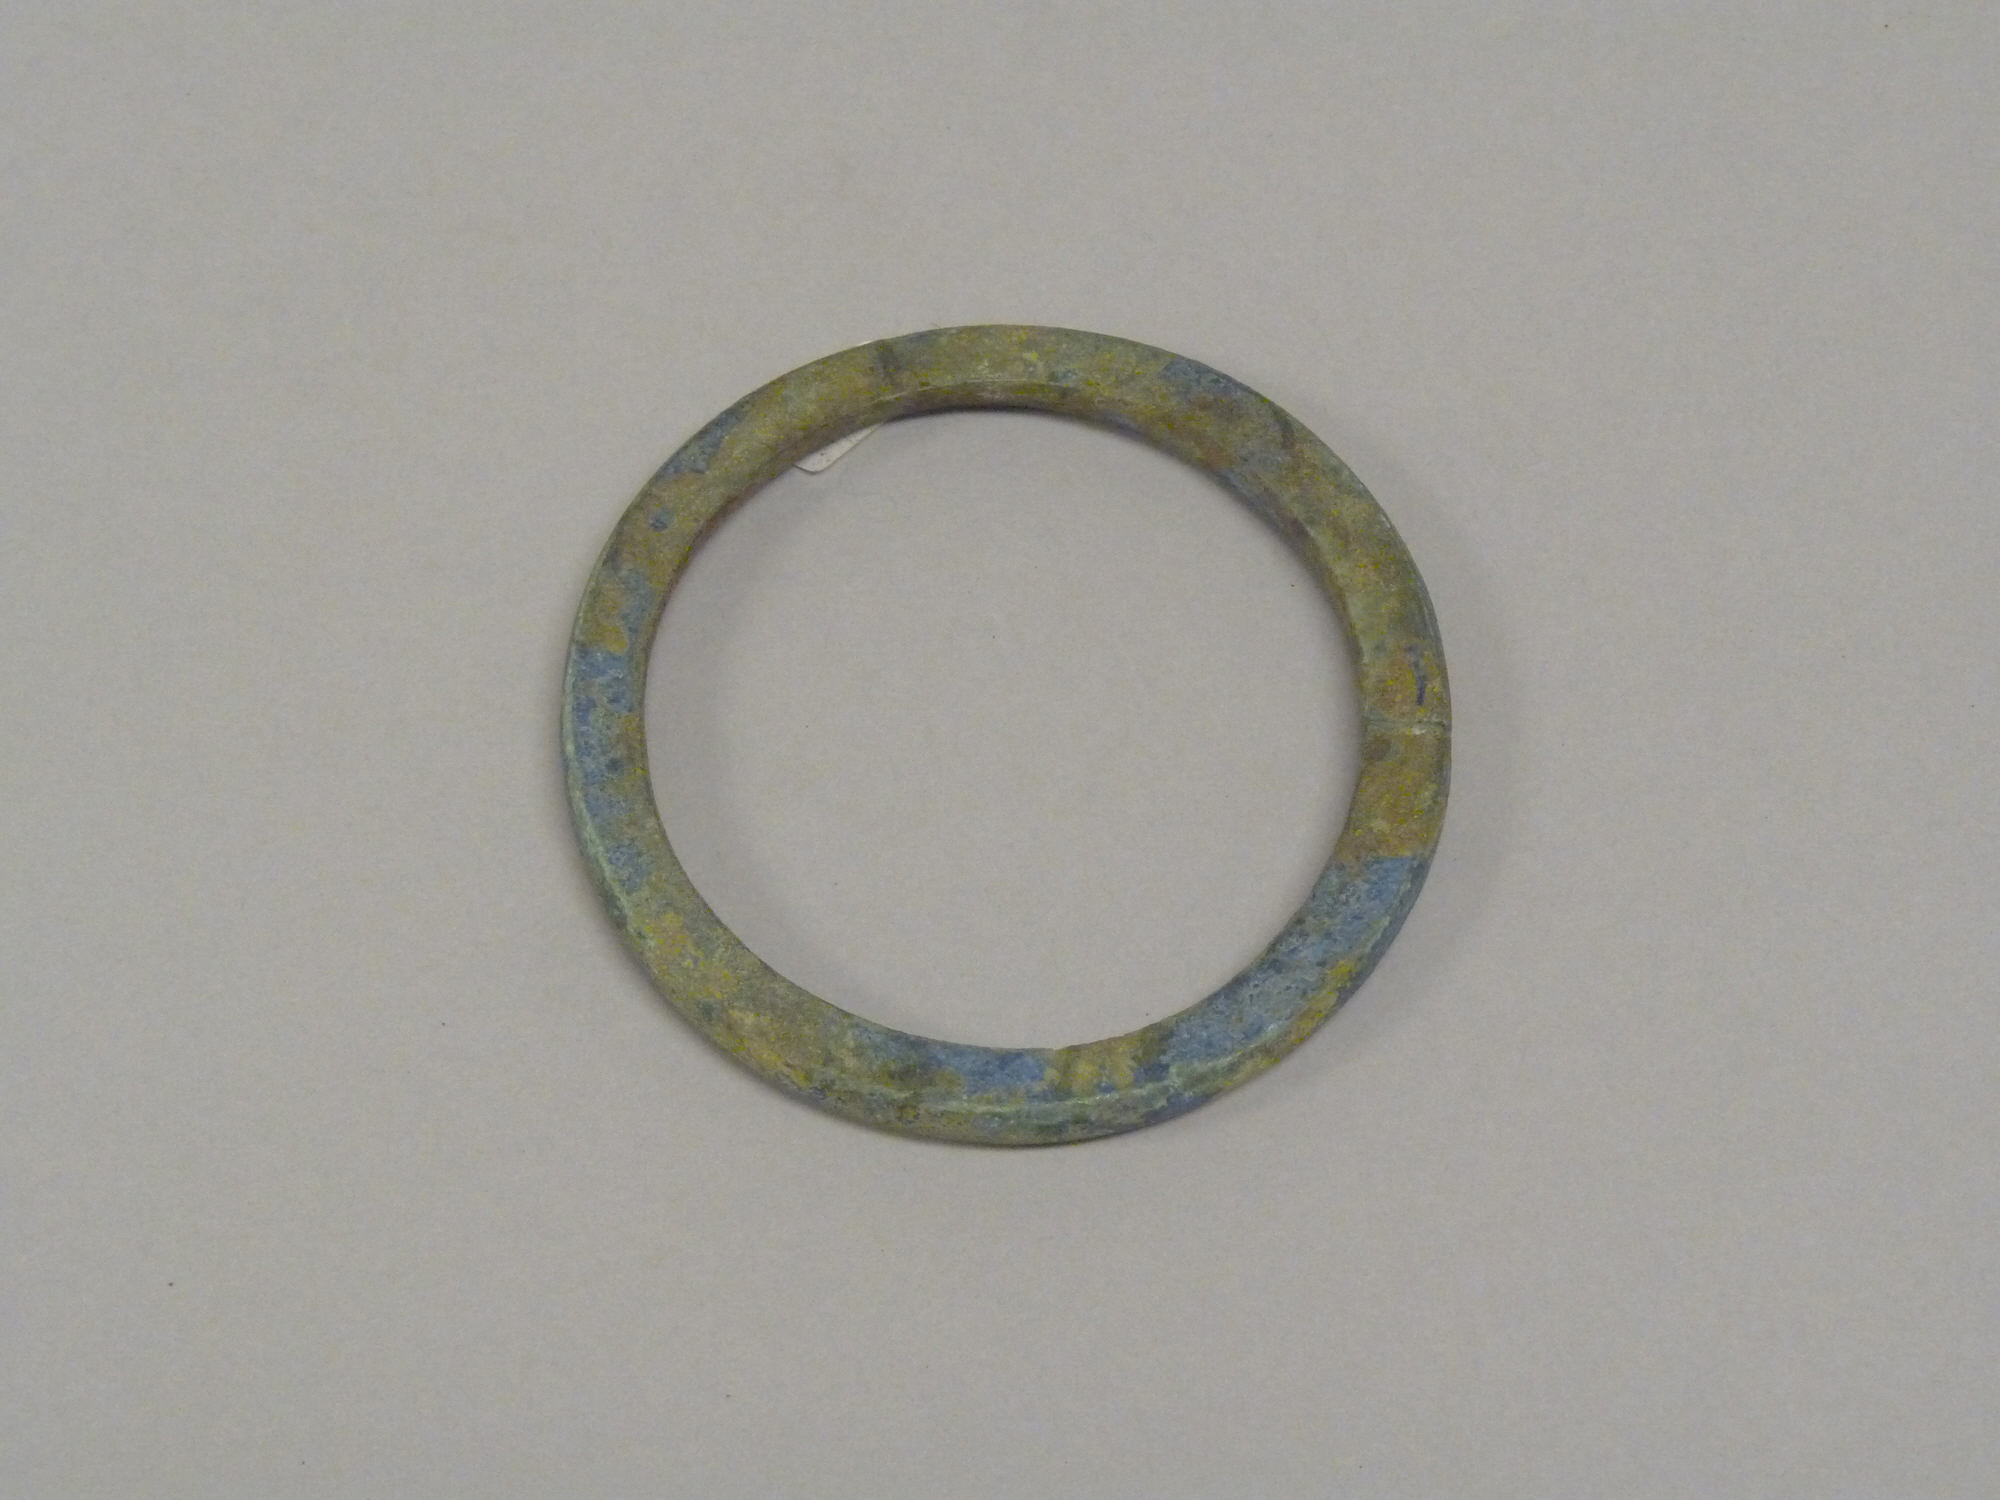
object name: one of a pair of bangle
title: One from a Pair of Solid Undecorated Bangles with Flat Surface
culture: thai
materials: bronze